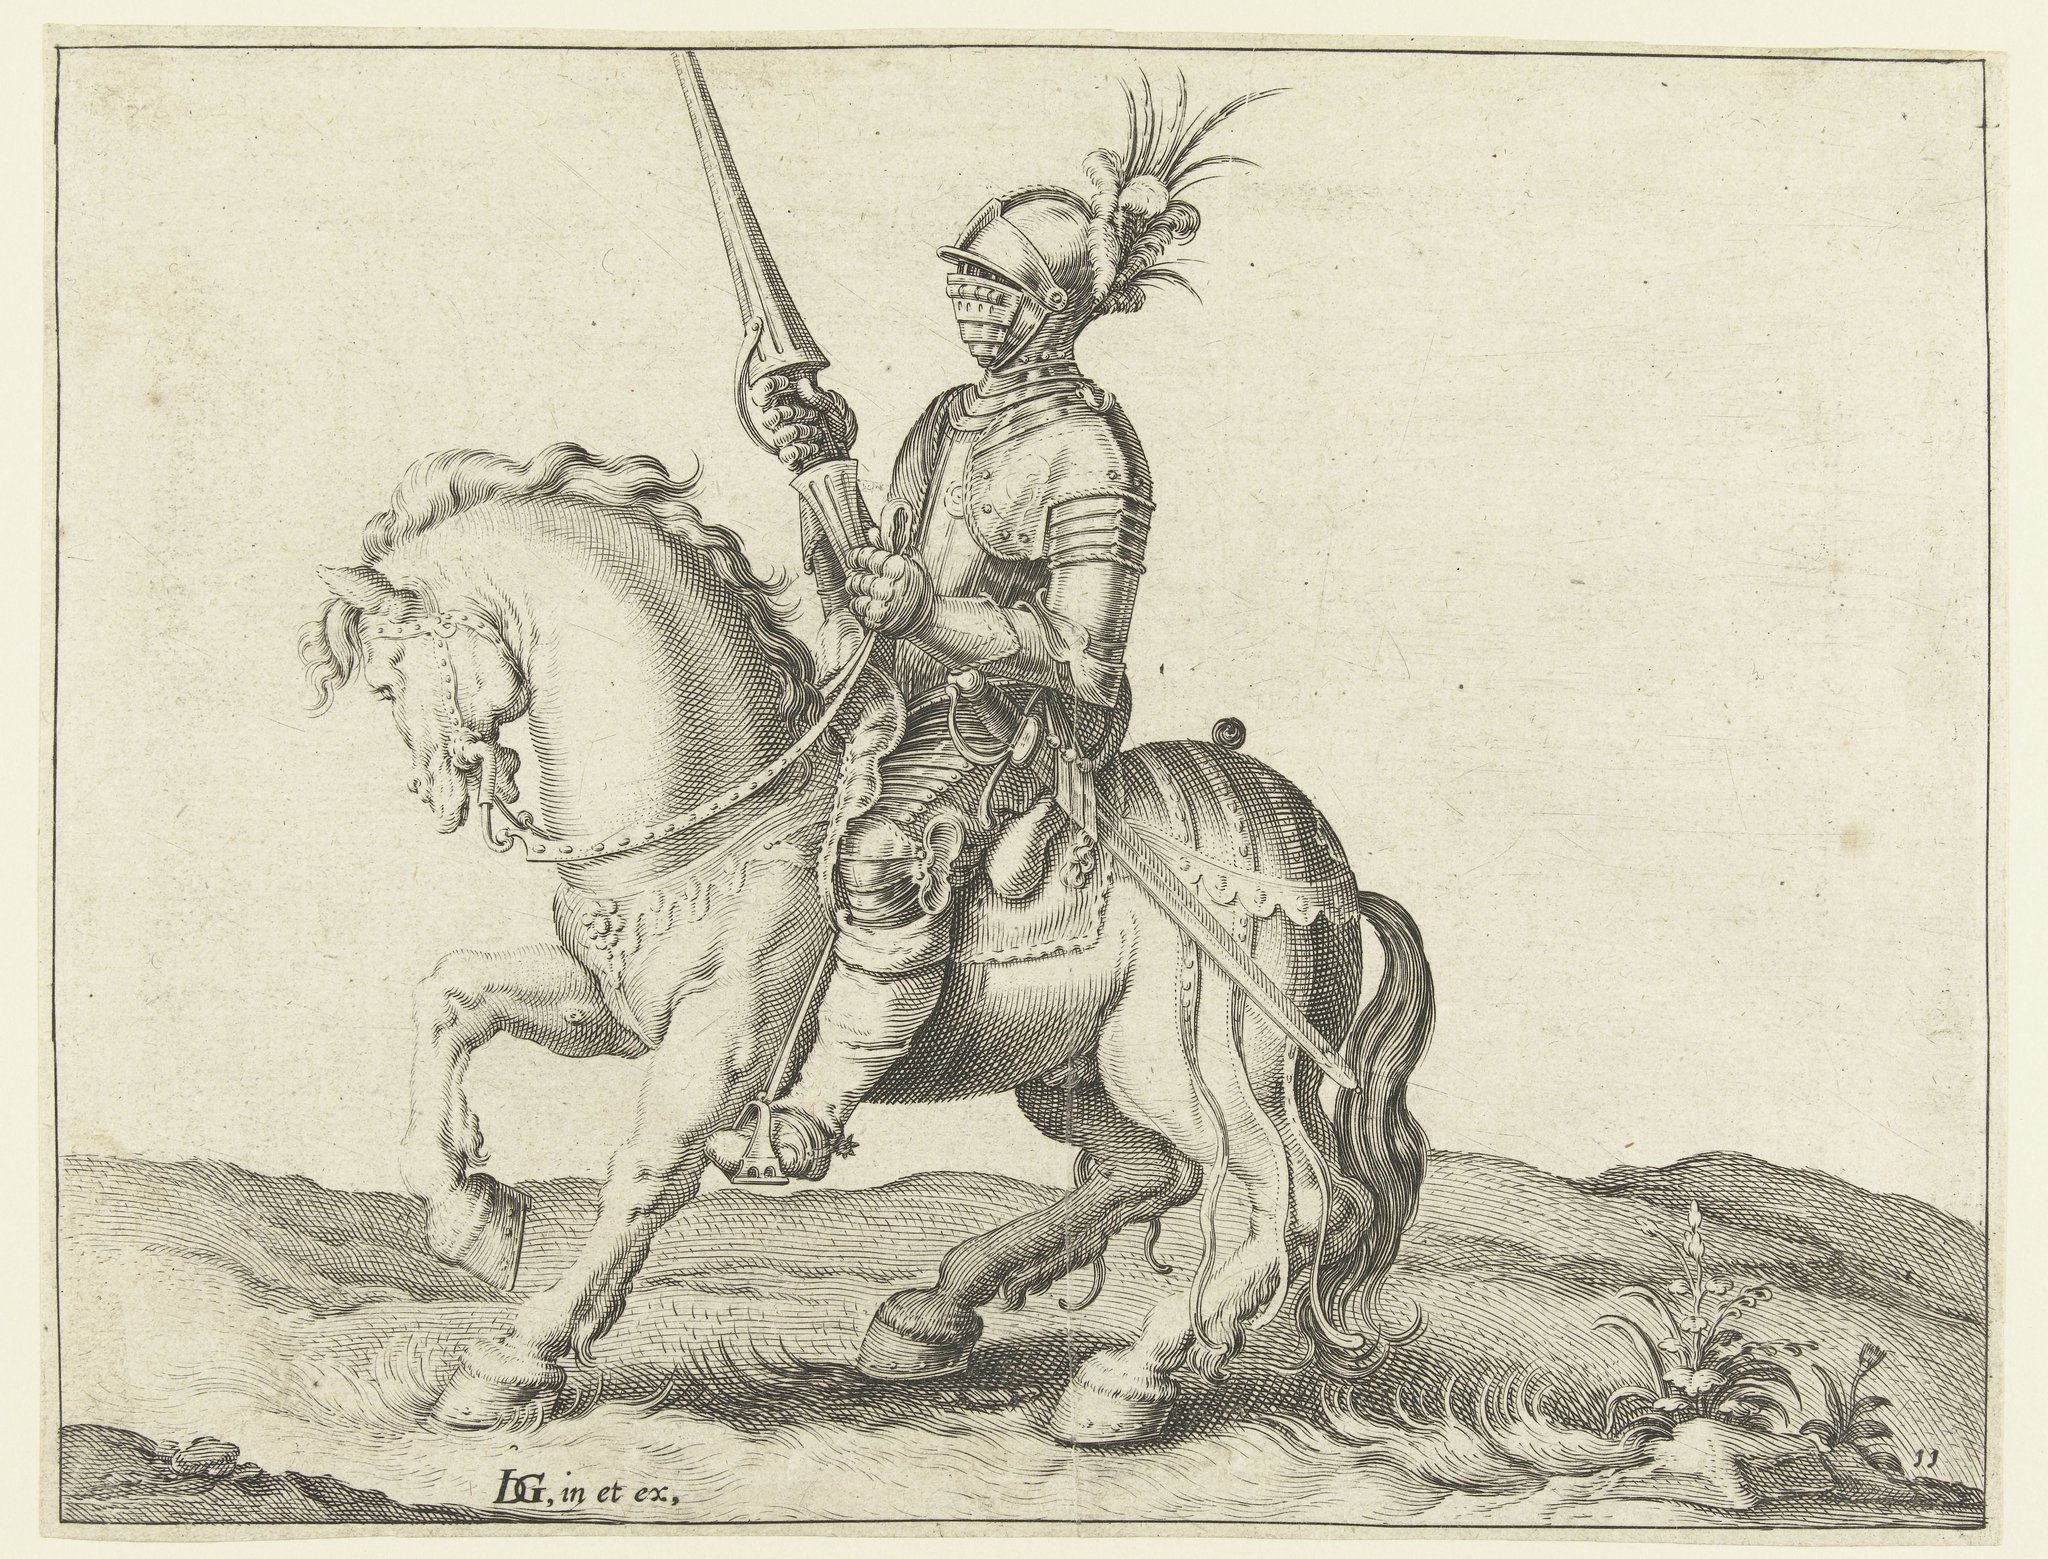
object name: print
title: Speerruiter met gesloten vizier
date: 1599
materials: paper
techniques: engraving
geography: leiden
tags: helved weapons, polearms (for striking, hacking, thrusting): lance, warfare; military affairs (+ cavalry, horsemen)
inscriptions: collector's mark: Lugt 2228a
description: Een geharnaste man te paard, naar links rijdend, met gesloten vizier en met een speer of lans rechtop in de rechterhand (een speerruiter). Deze prent is onderdeel van een serie van 22 genummerde prenten: een titelprent, 20 prenten waarop één of enkele verschillende typen (meest geharnaste) ruiters zijn weergegeven, en een prent met een ruitergevecht.